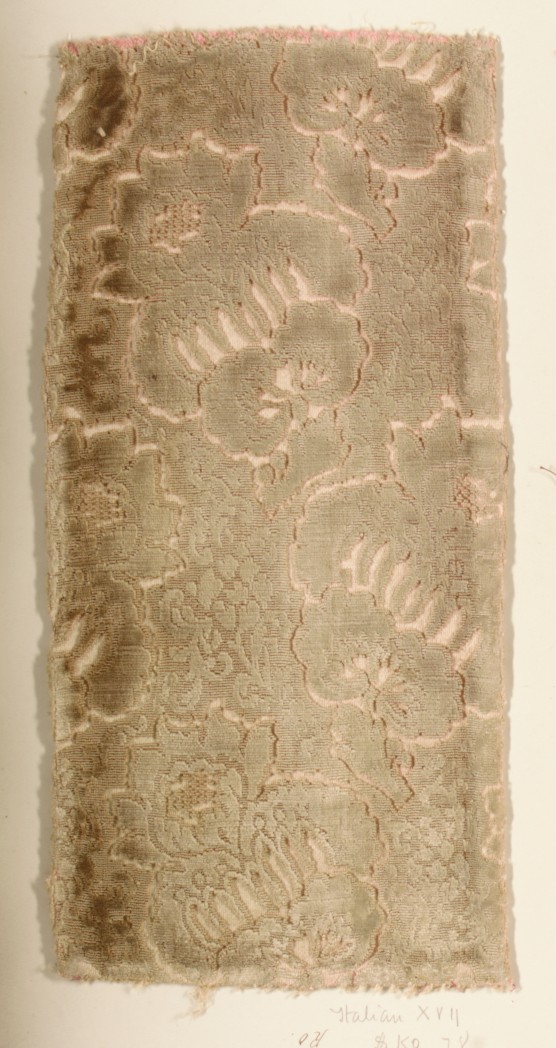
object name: fragment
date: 1667-1700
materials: silk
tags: flowers